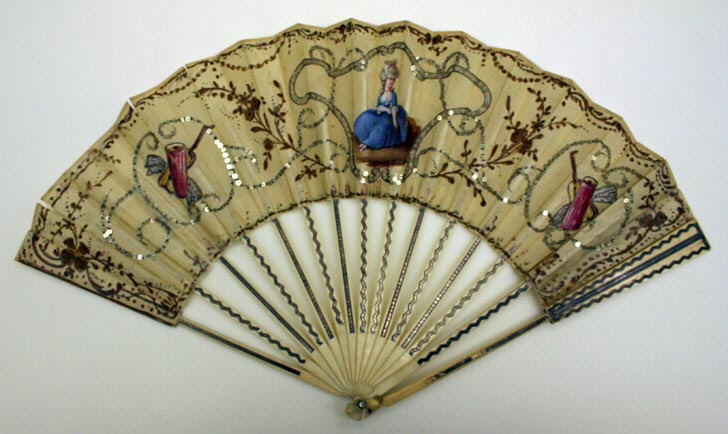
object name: fan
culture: american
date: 1830-1839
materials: ivory, silk, silver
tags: women